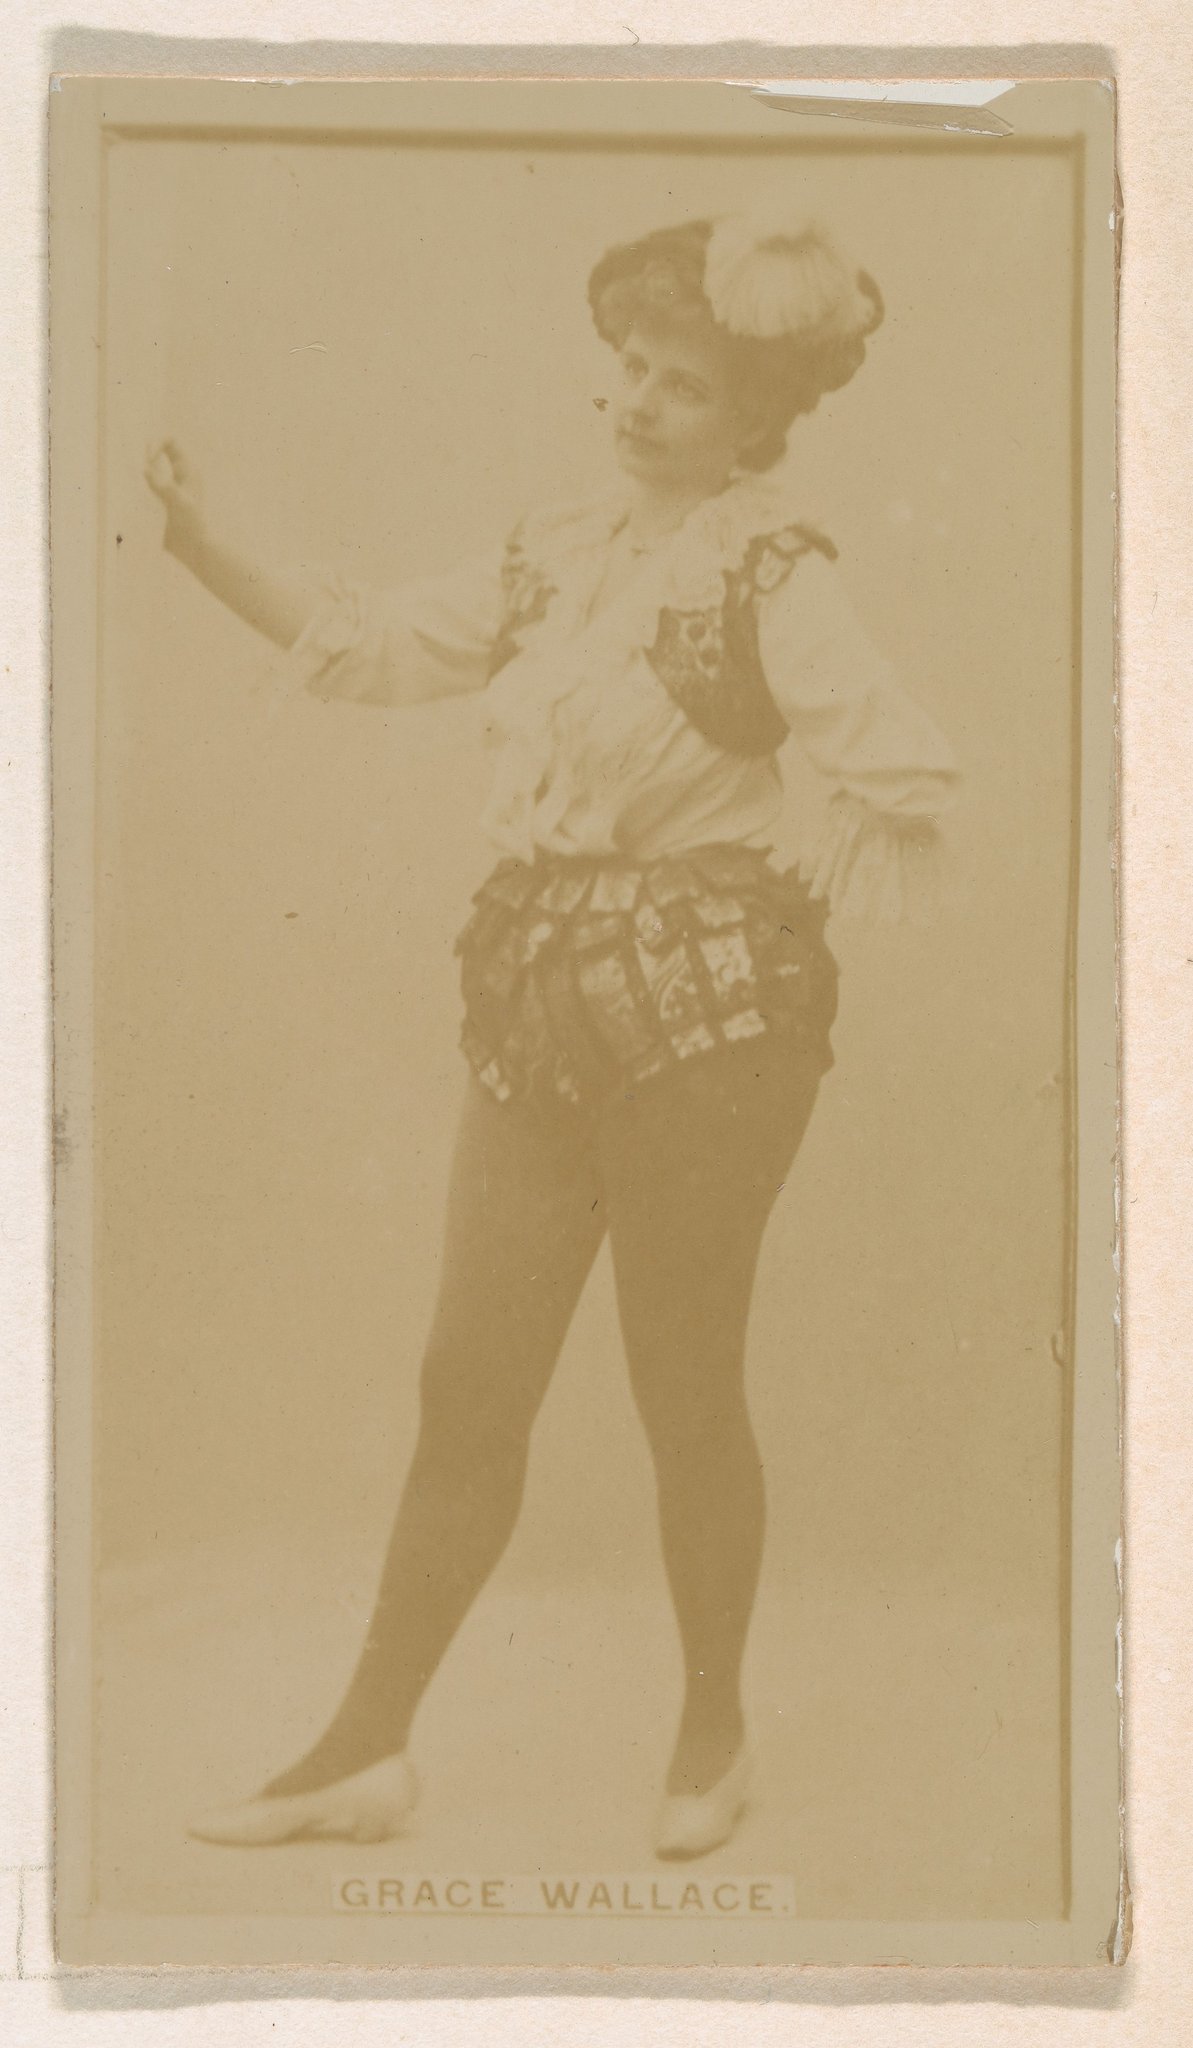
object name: photograph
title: Grace Wallace, from the Actresses series (N245) issued by Kinney Brothers to promote Sweet Caporal Cigarettes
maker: kinney brothers tobacco company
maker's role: publisher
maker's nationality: american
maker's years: 1869-2011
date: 1890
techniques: albumen silver print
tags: portraits,women,actresses